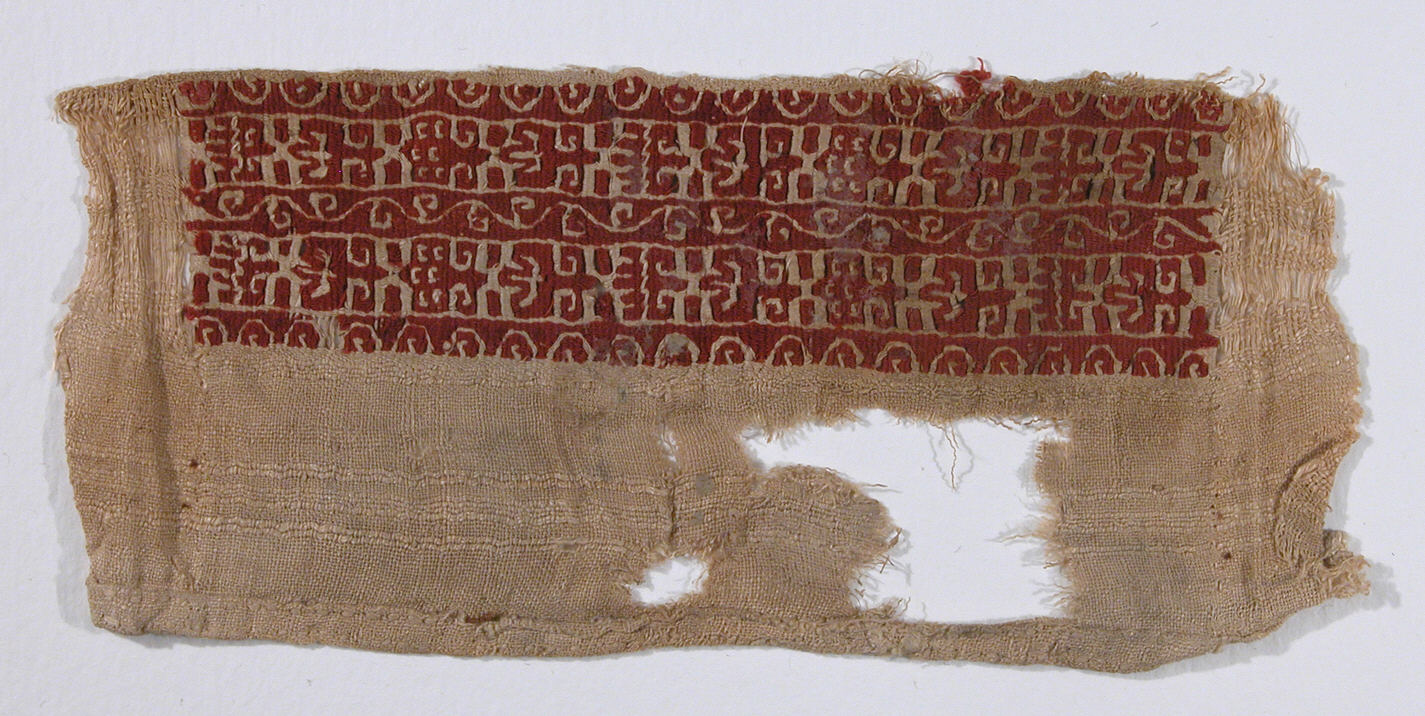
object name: fragment of a sleeve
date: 401-600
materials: linen, wool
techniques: weave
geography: egypt